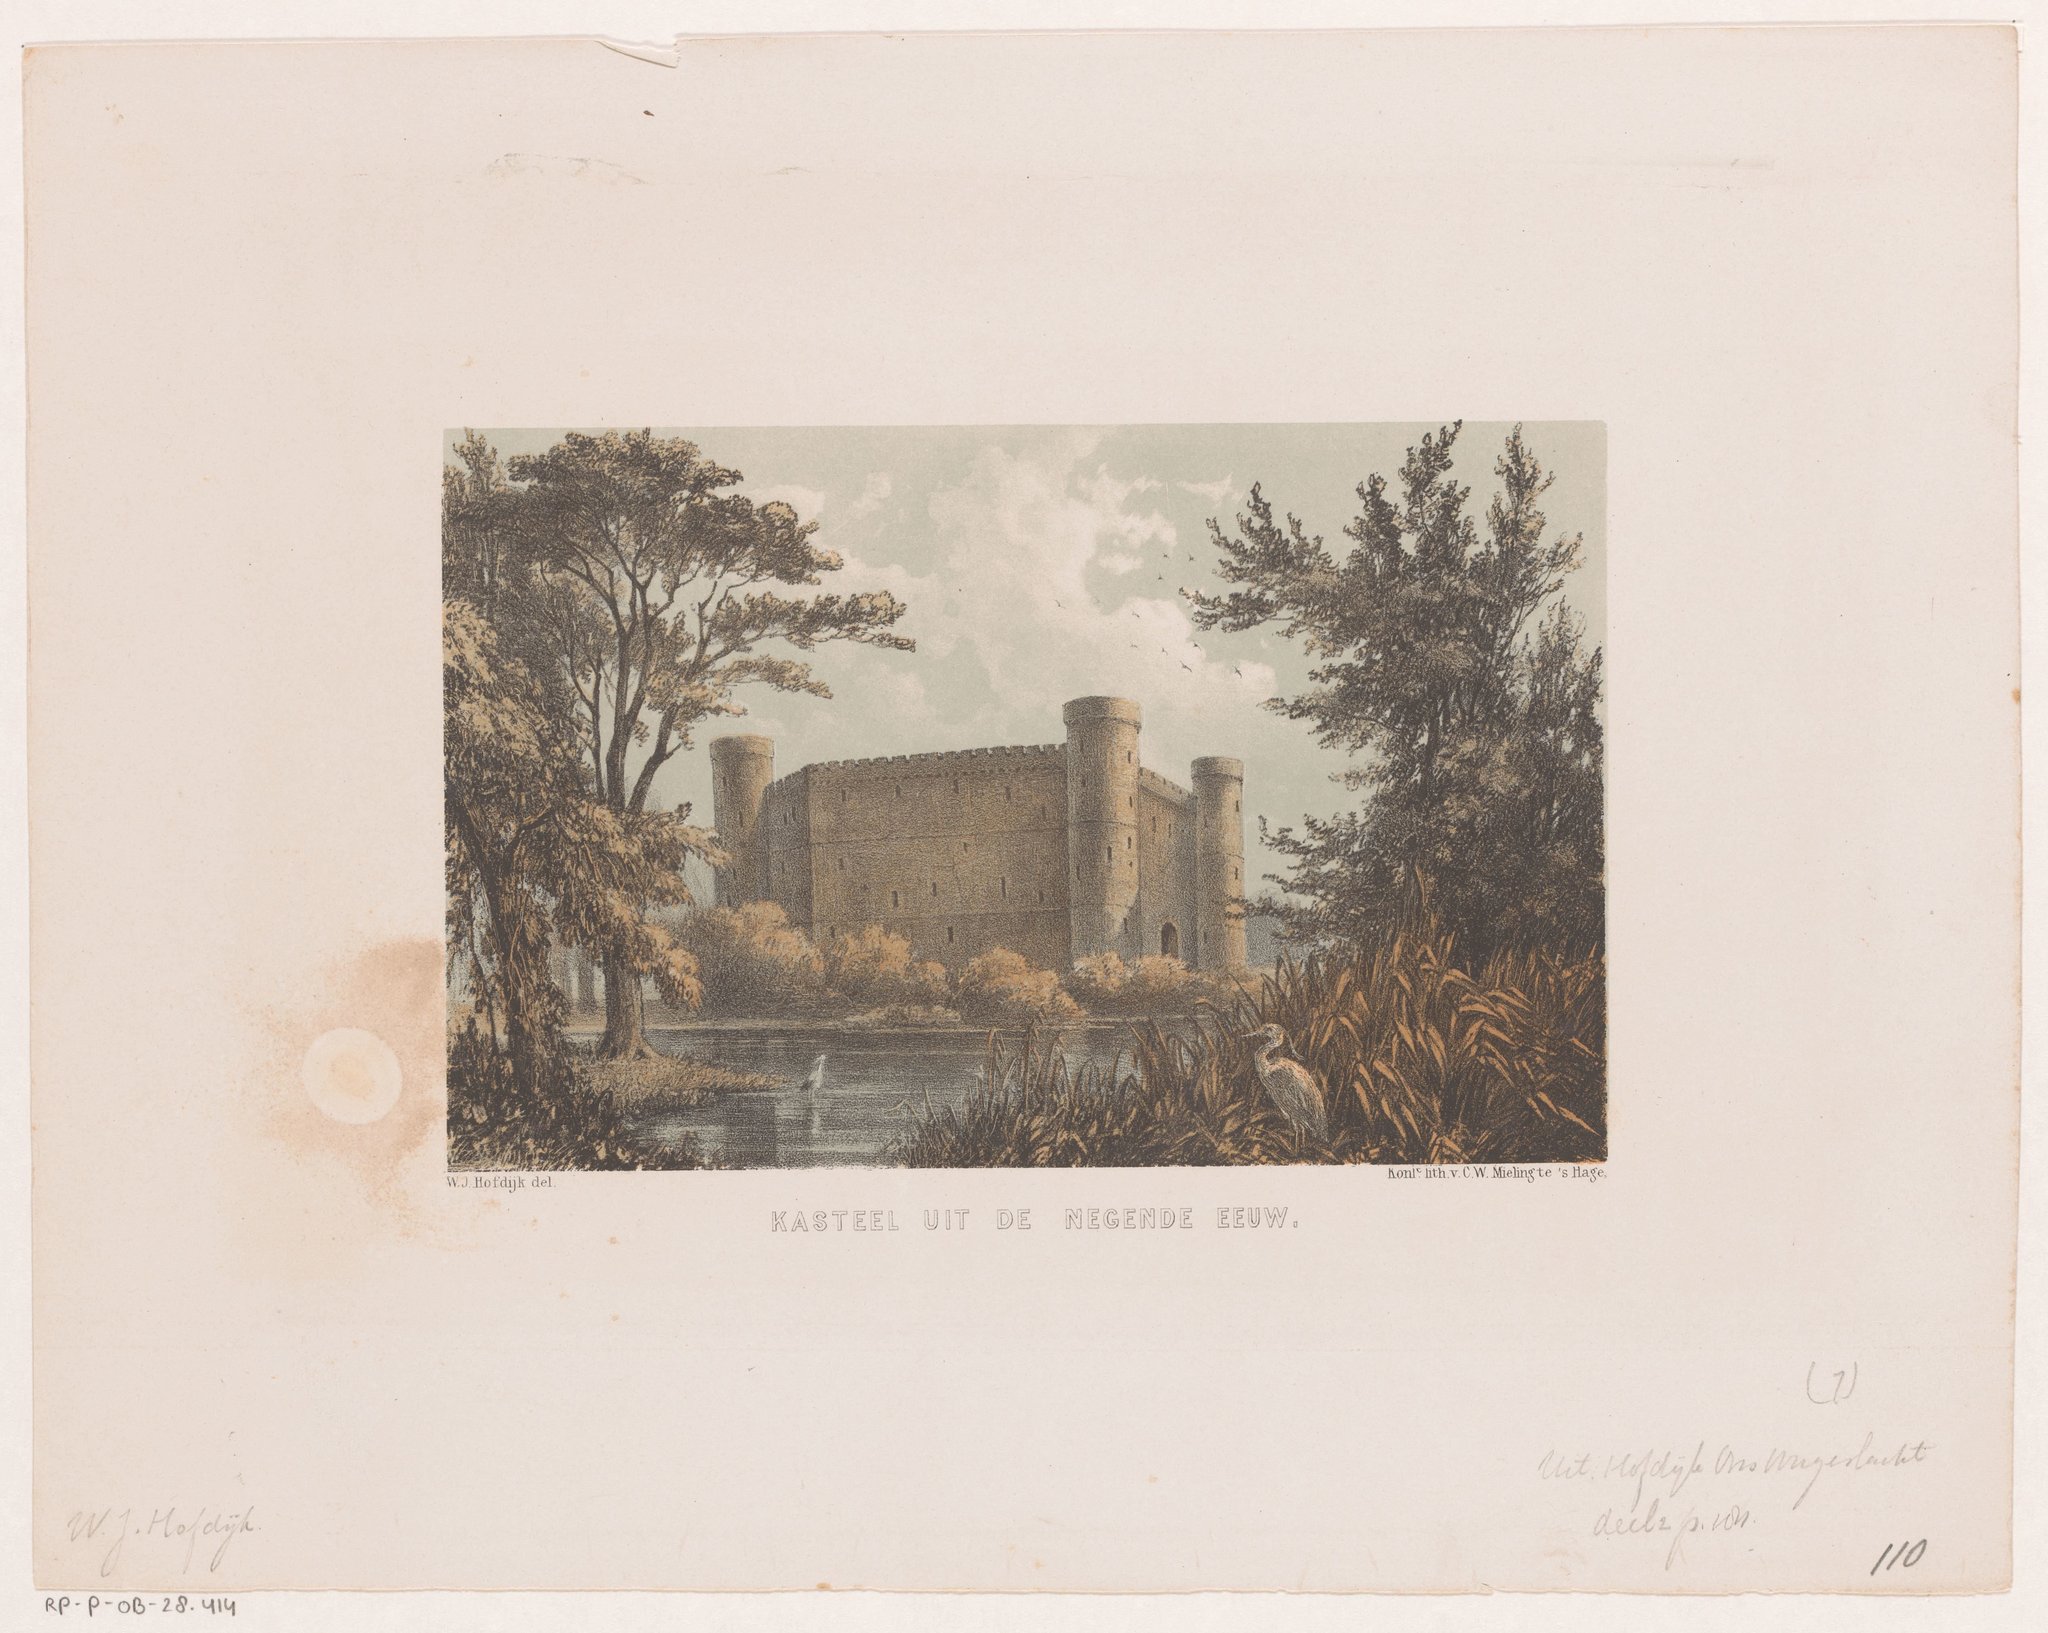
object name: print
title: Kasteel, 9e eeuw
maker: willem jacob hofdijk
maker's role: painter, print maker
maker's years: 1816-1888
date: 1857-1864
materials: paper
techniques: tone lithography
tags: castle, netherlands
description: Illustratie voor: W.J. Hofdijk, Ons voorgeslacht in zijn dagelyksch leven geschilderd, Kruseman, Haarlem 1859-1864, dl. 2, p. 181.